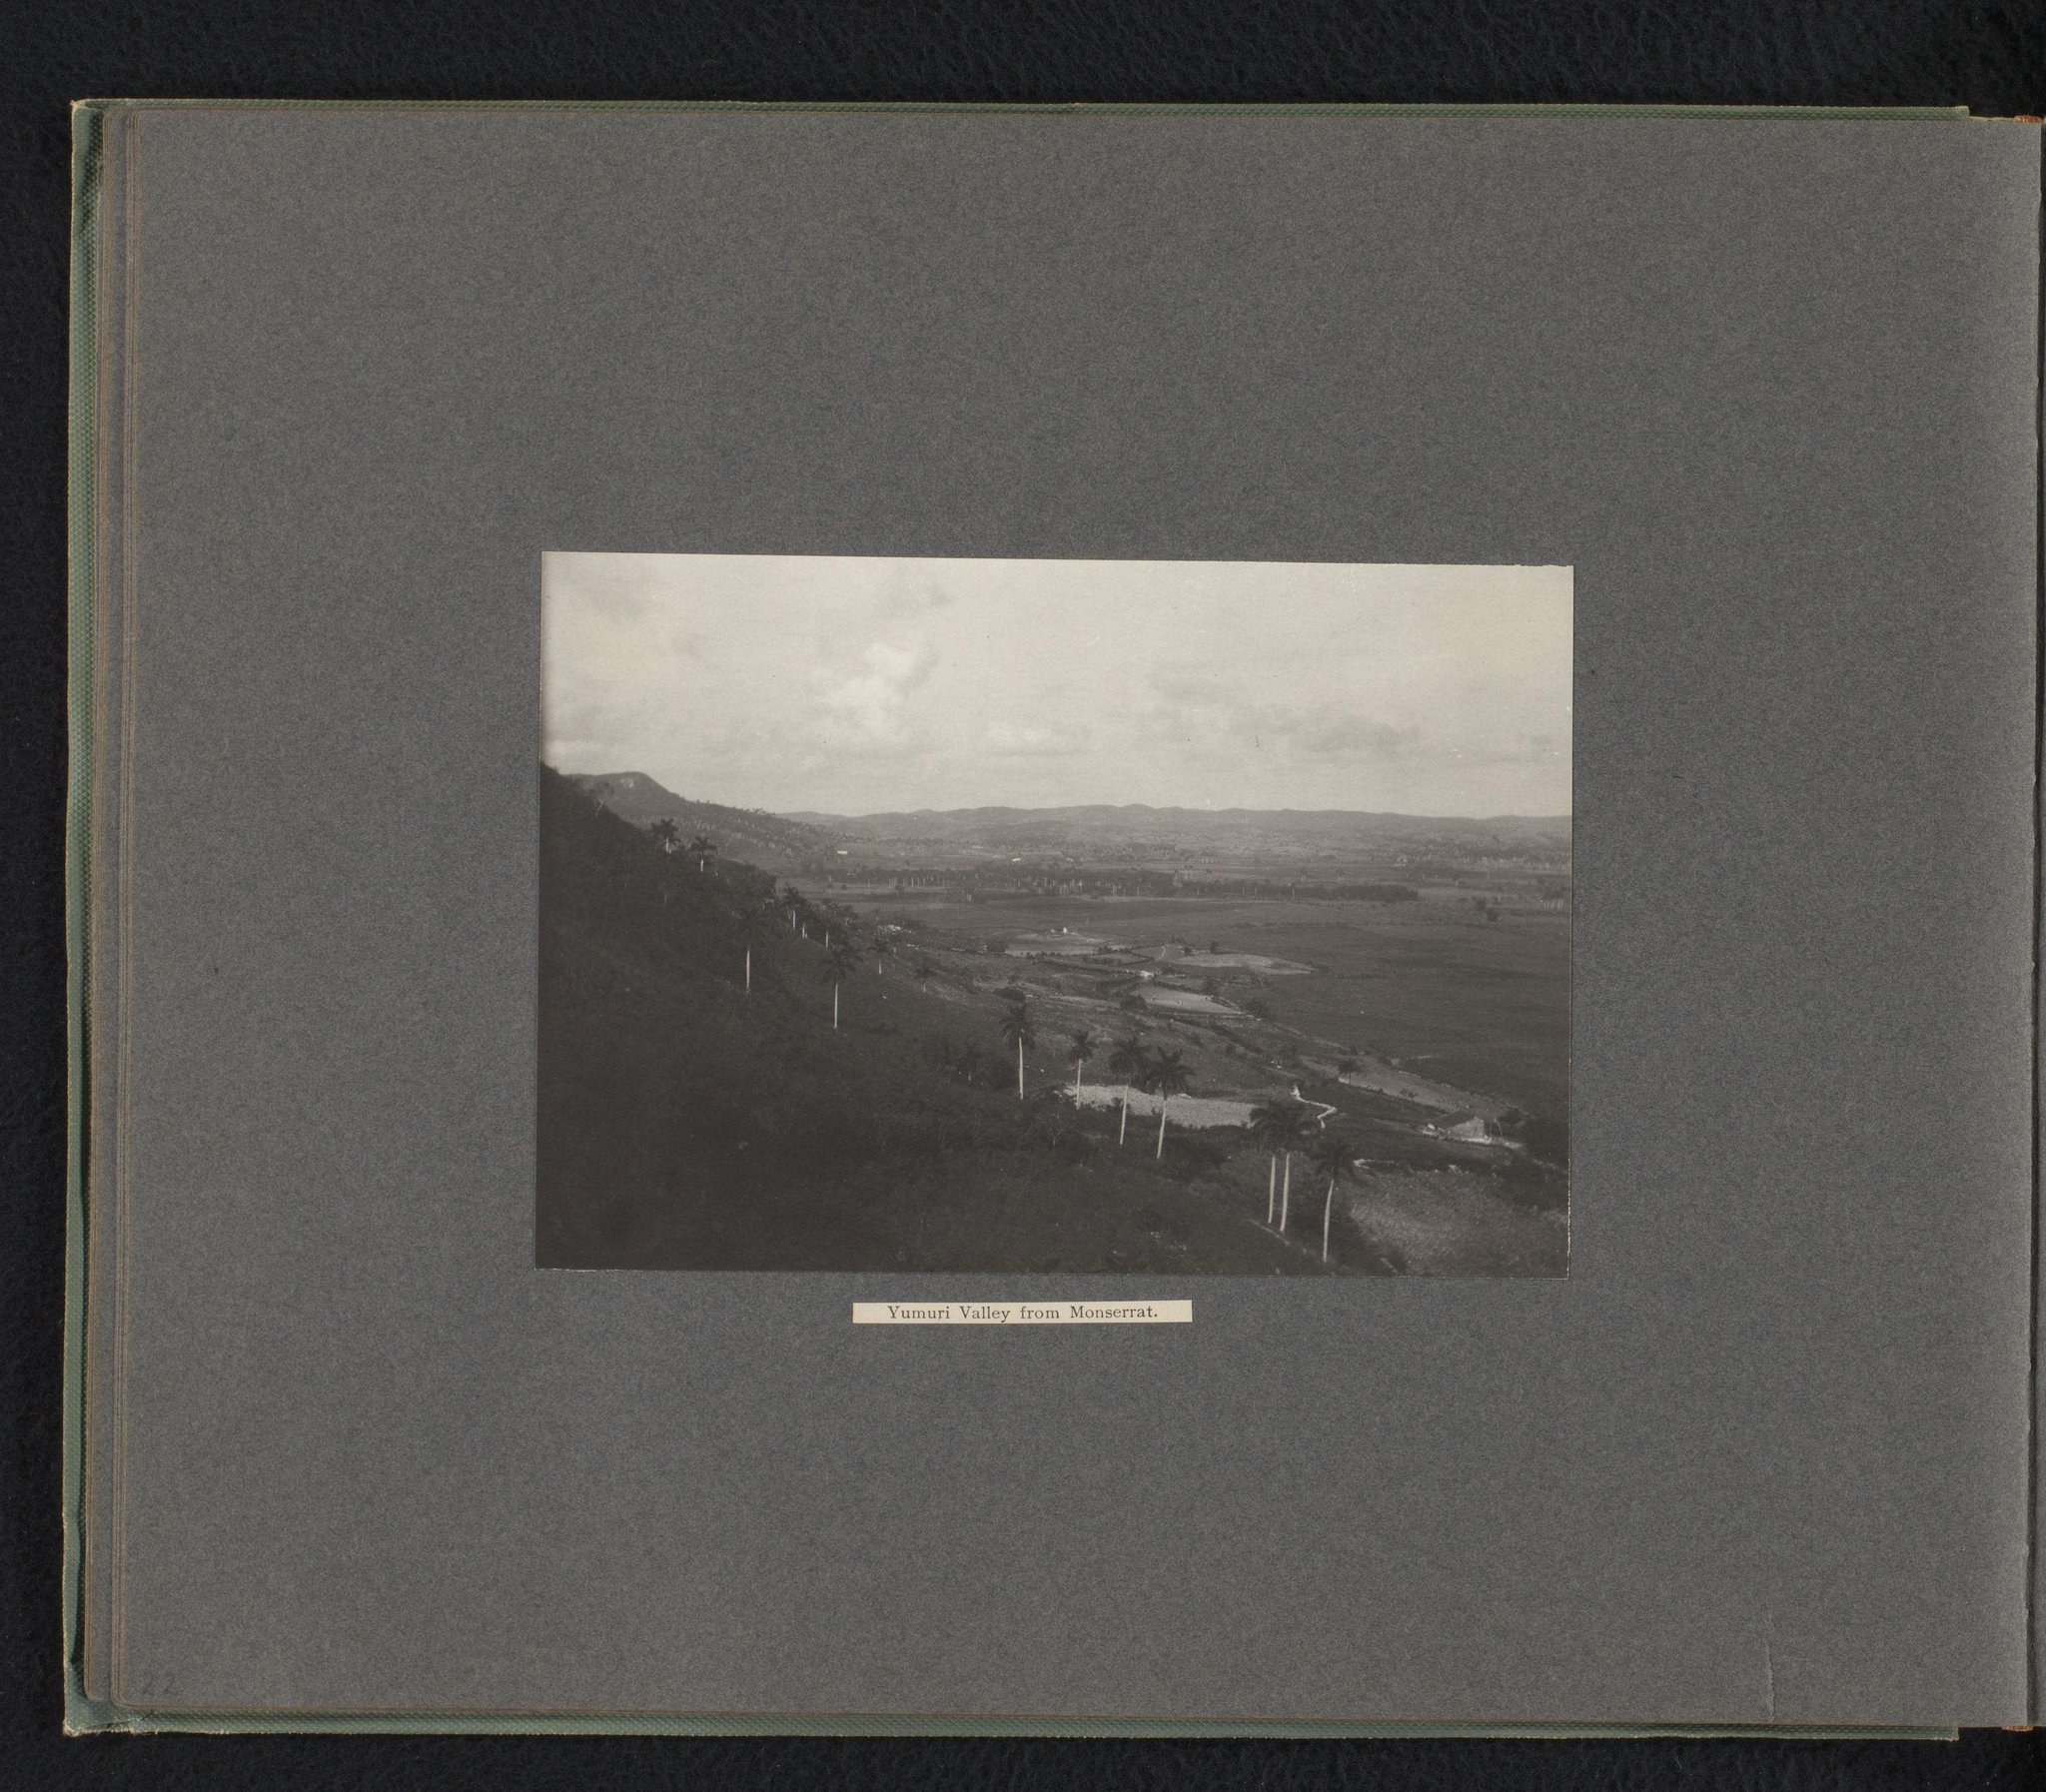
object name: album leaf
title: Gezicht op het Yumuridal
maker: Anonymous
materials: paper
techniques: platinum process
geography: matanzas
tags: dale, valley